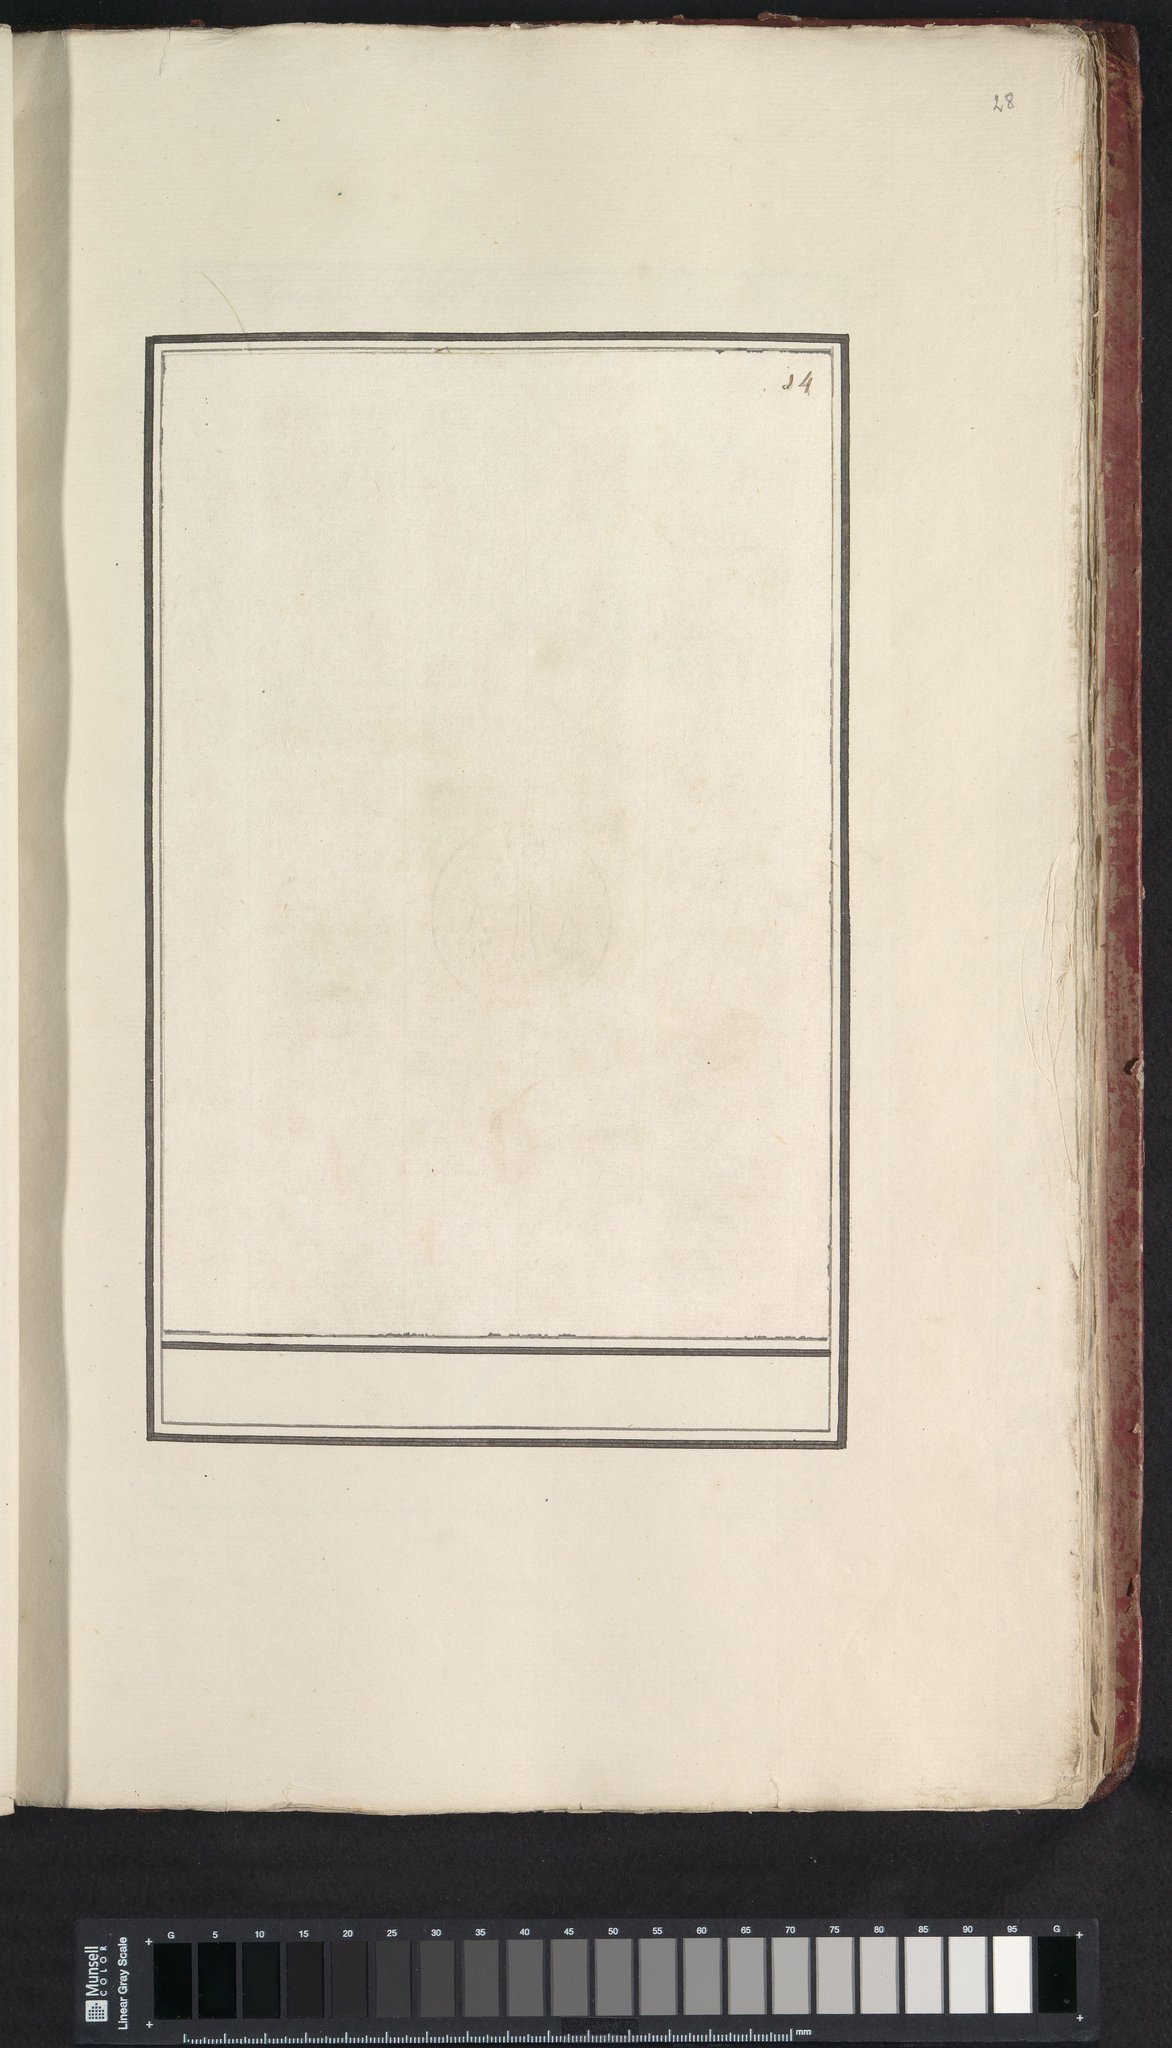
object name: drawing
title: Omlijsting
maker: Anonymous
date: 1809-1814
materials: ink, paper, pencil, watercolor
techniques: brush, pen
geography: southern netherlands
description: Lege omlijsting. Genummerd rechtsboven: 14. Onderdeel van het eerste album met tekeningen van bloemen en planten. Achtste van twaalf albums met tekeningen van dieren, vogels en planten bekend rond 1600, gemaakt in opdracht van keizer Rudolf II. Met toelichting in Nederlands, Latijn en Frans.